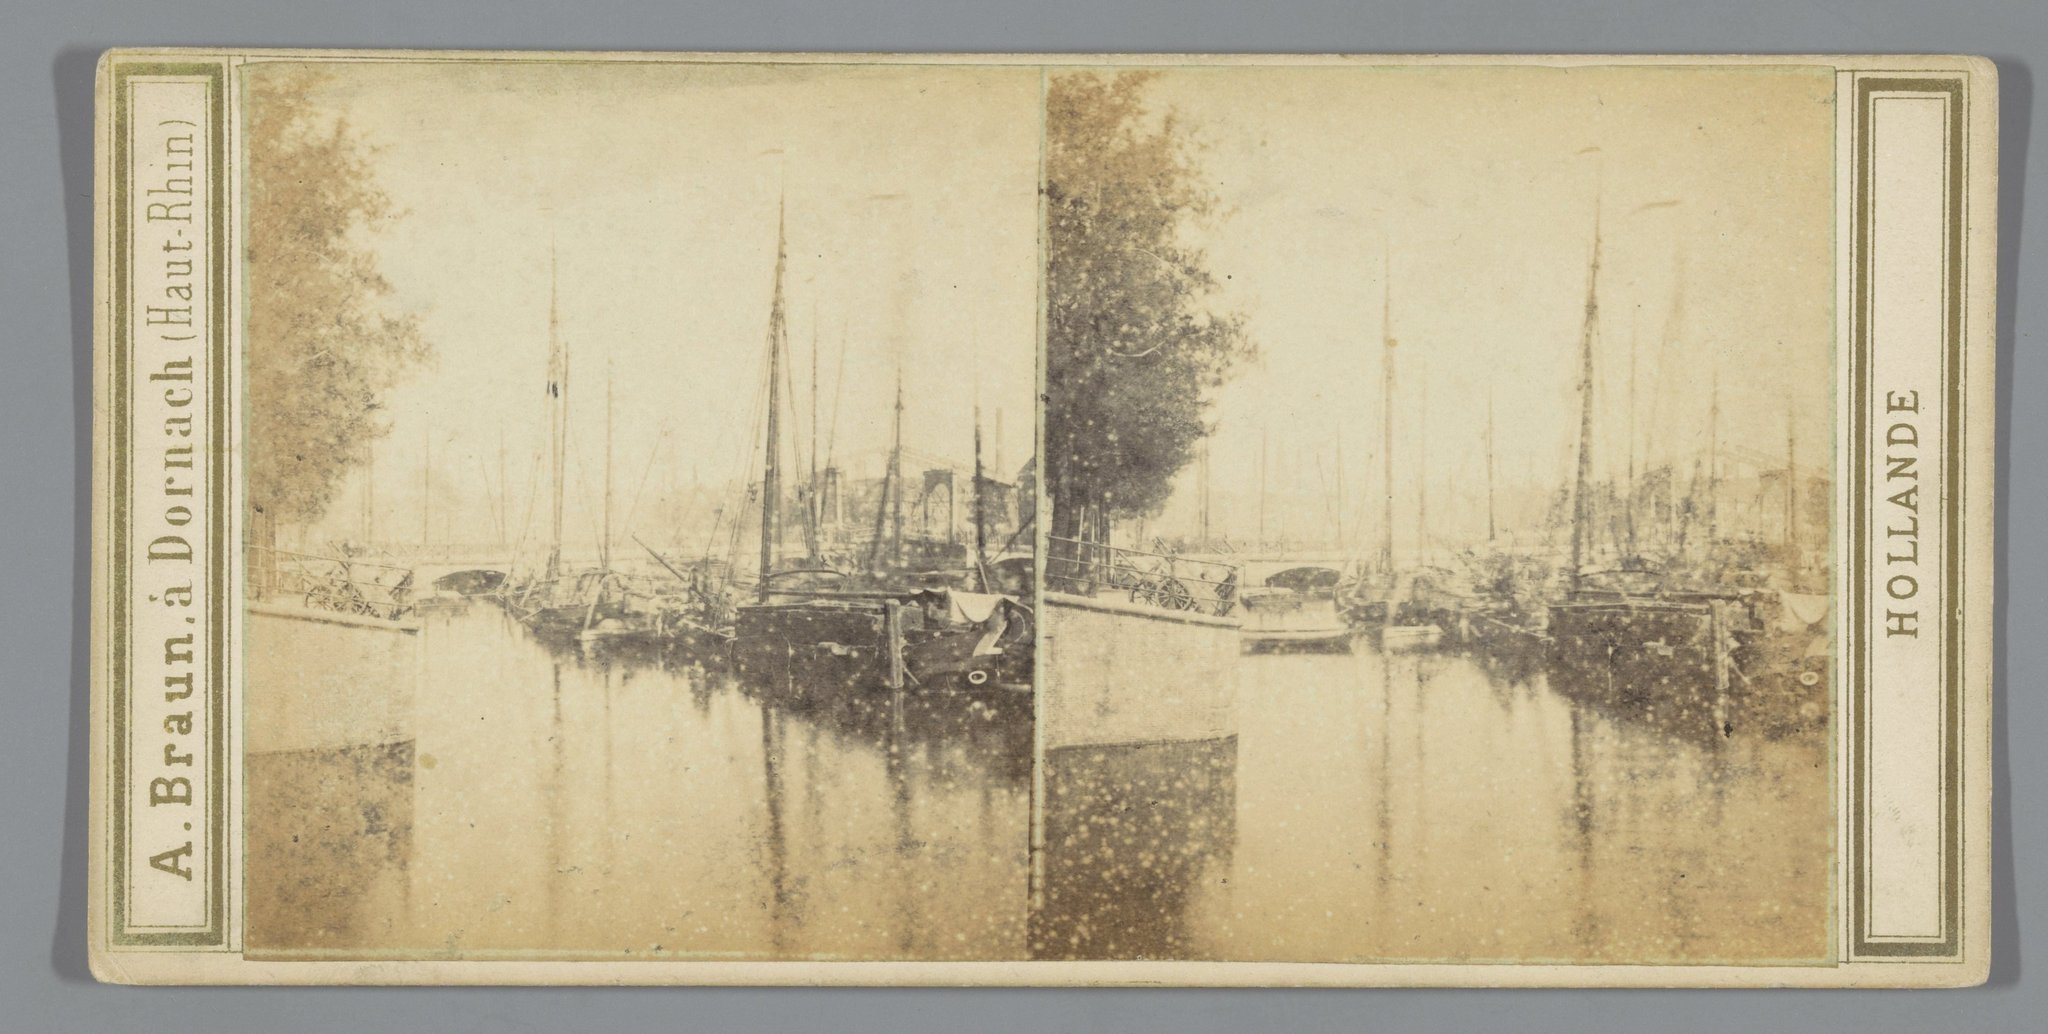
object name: stereograph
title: Gezicht op de Amstel, Amsterdam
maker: Anonymous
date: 1860-1866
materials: cardboard, paper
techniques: albumen print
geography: amstelkade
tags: canals, waters (in city), ships (in general) - cc - more than one ship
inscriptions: number: ‘No. 3988.’